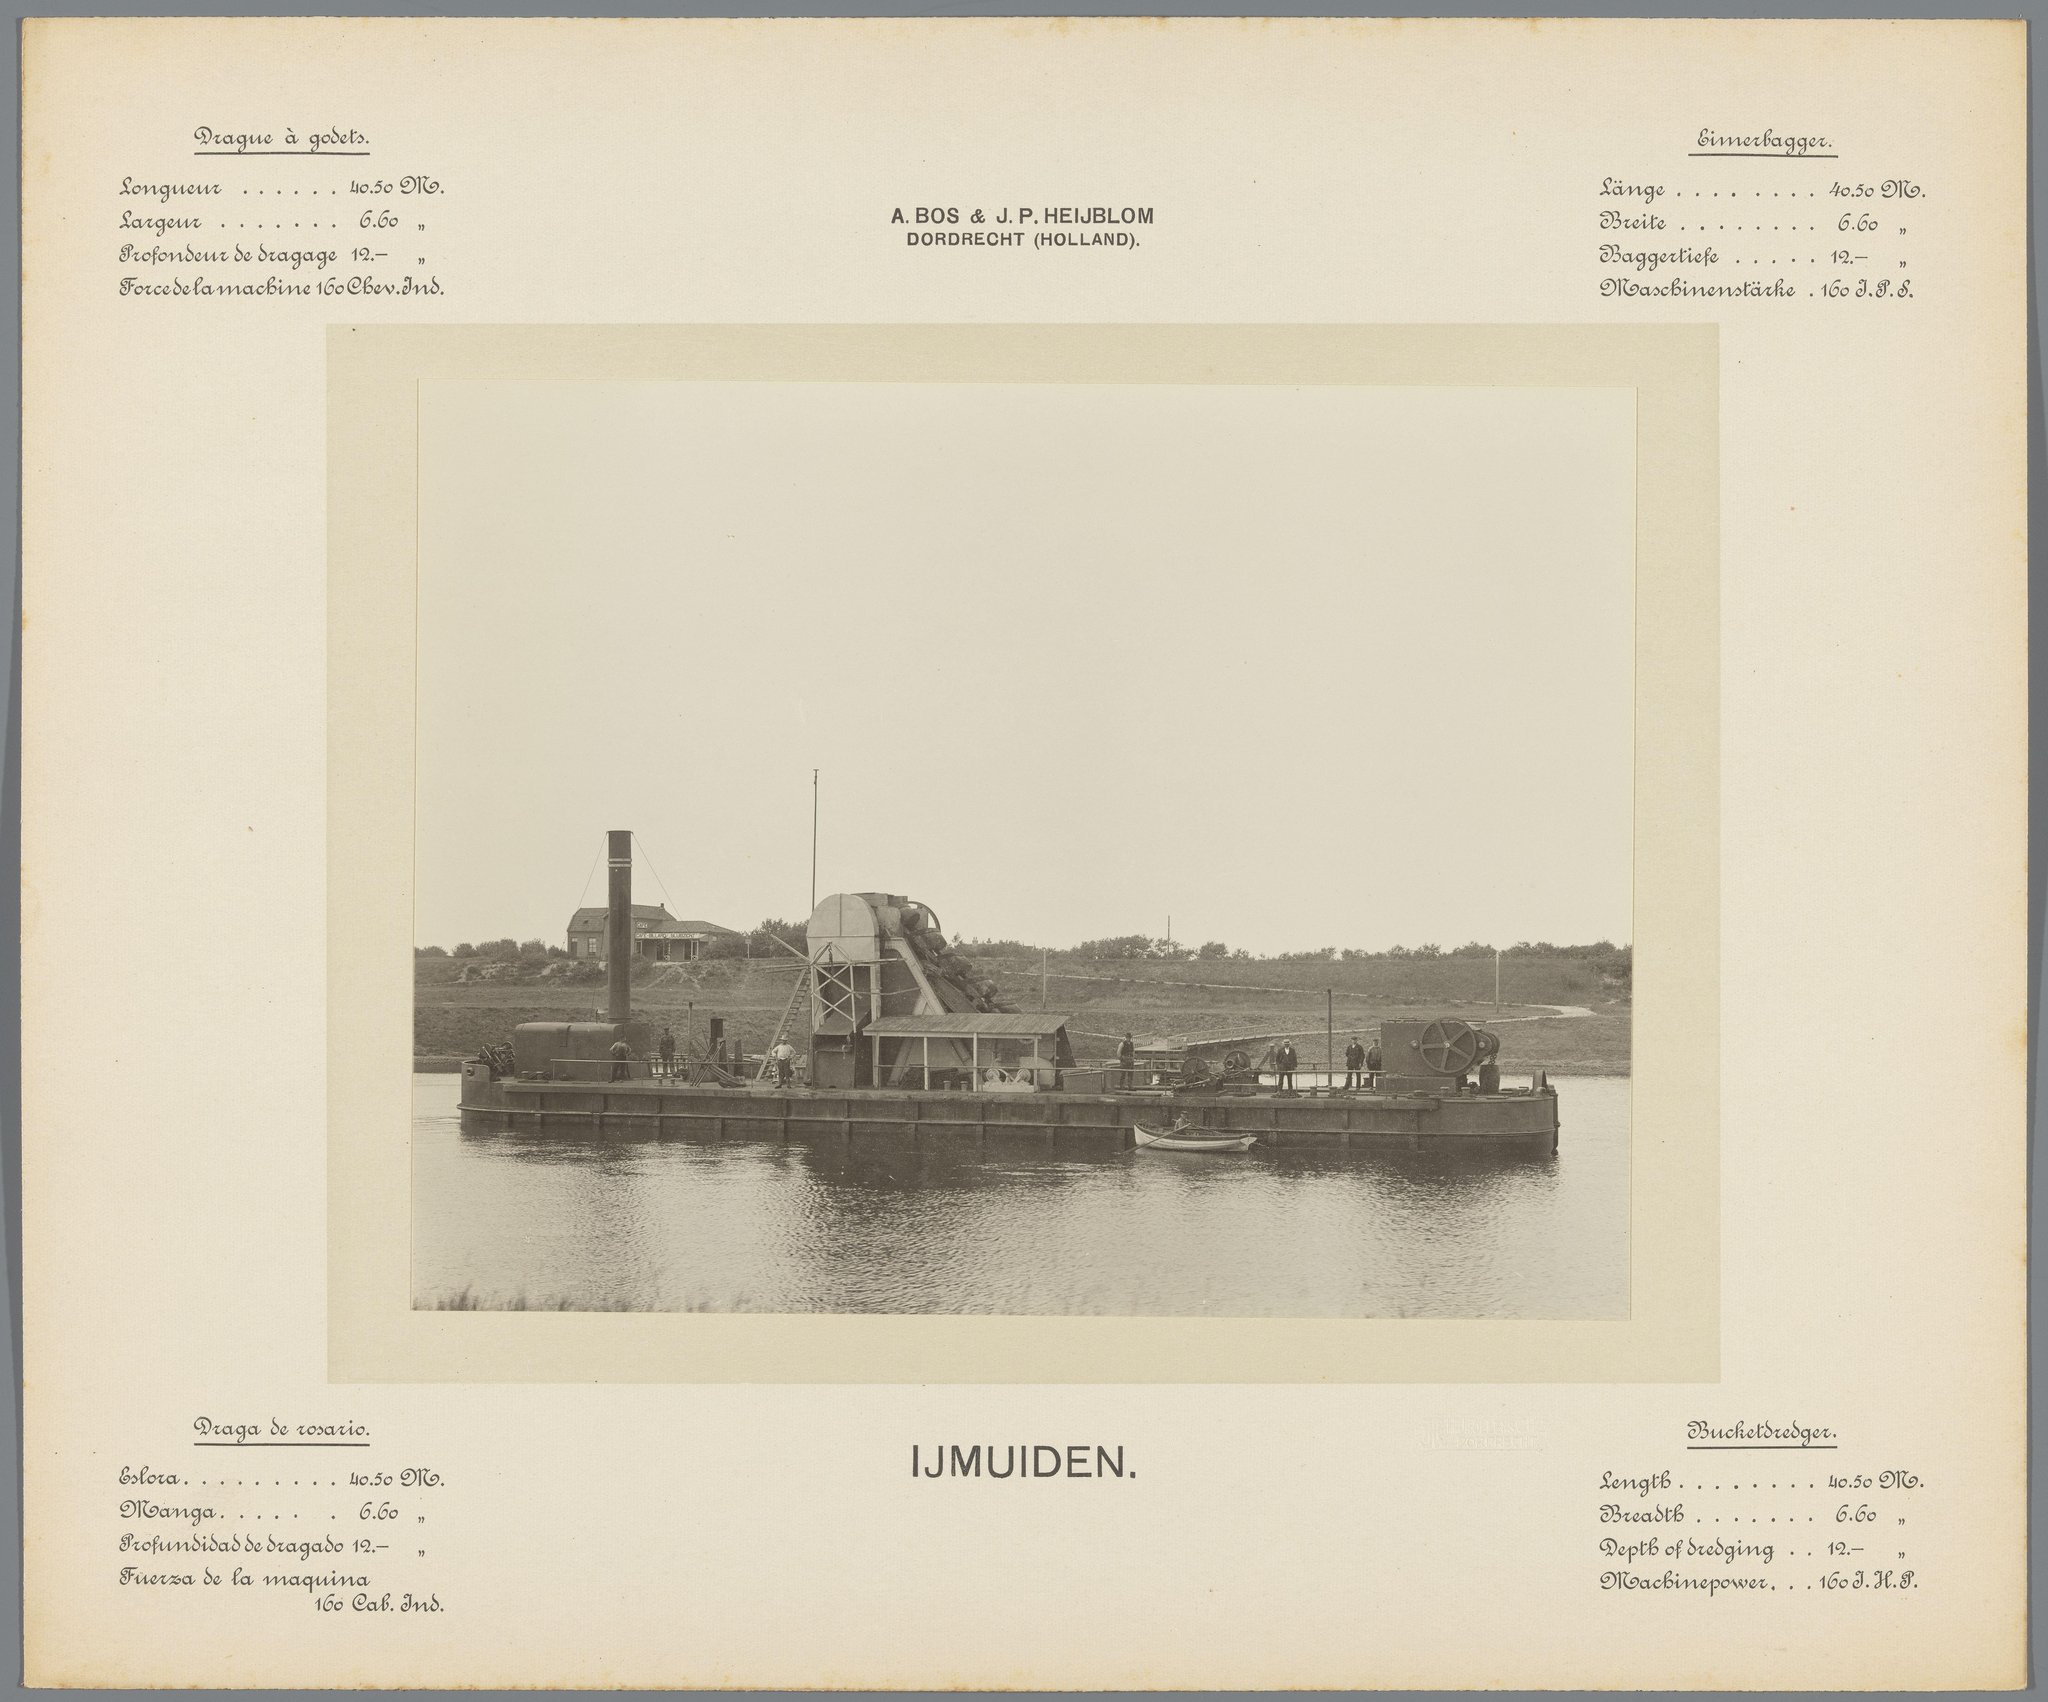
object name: photograph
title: IJmuiden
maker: henricus jacobus tollens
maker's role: painter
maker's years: 1864-1936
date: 1900-1910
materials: cardboard, photographic support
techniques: gelatin silver print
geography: dordrecht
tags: machine driven by steam, steamship, motorship (+ propulsion of vehicle, ship, etc. by steam), dredge, dredging machine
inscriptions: name: ‘H.J. Tollens C. Hzn. Dordrecht’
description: Emmerbaggermolen IJmuiden. Foto geplakt op karton met technische informatie over het schip in Duits, Frans, Spaans en Engels. Onderdeel van de map met 44 foto's van baggerschepen van de firma A. Bos & J.P. Heijblom te Dordrecht.